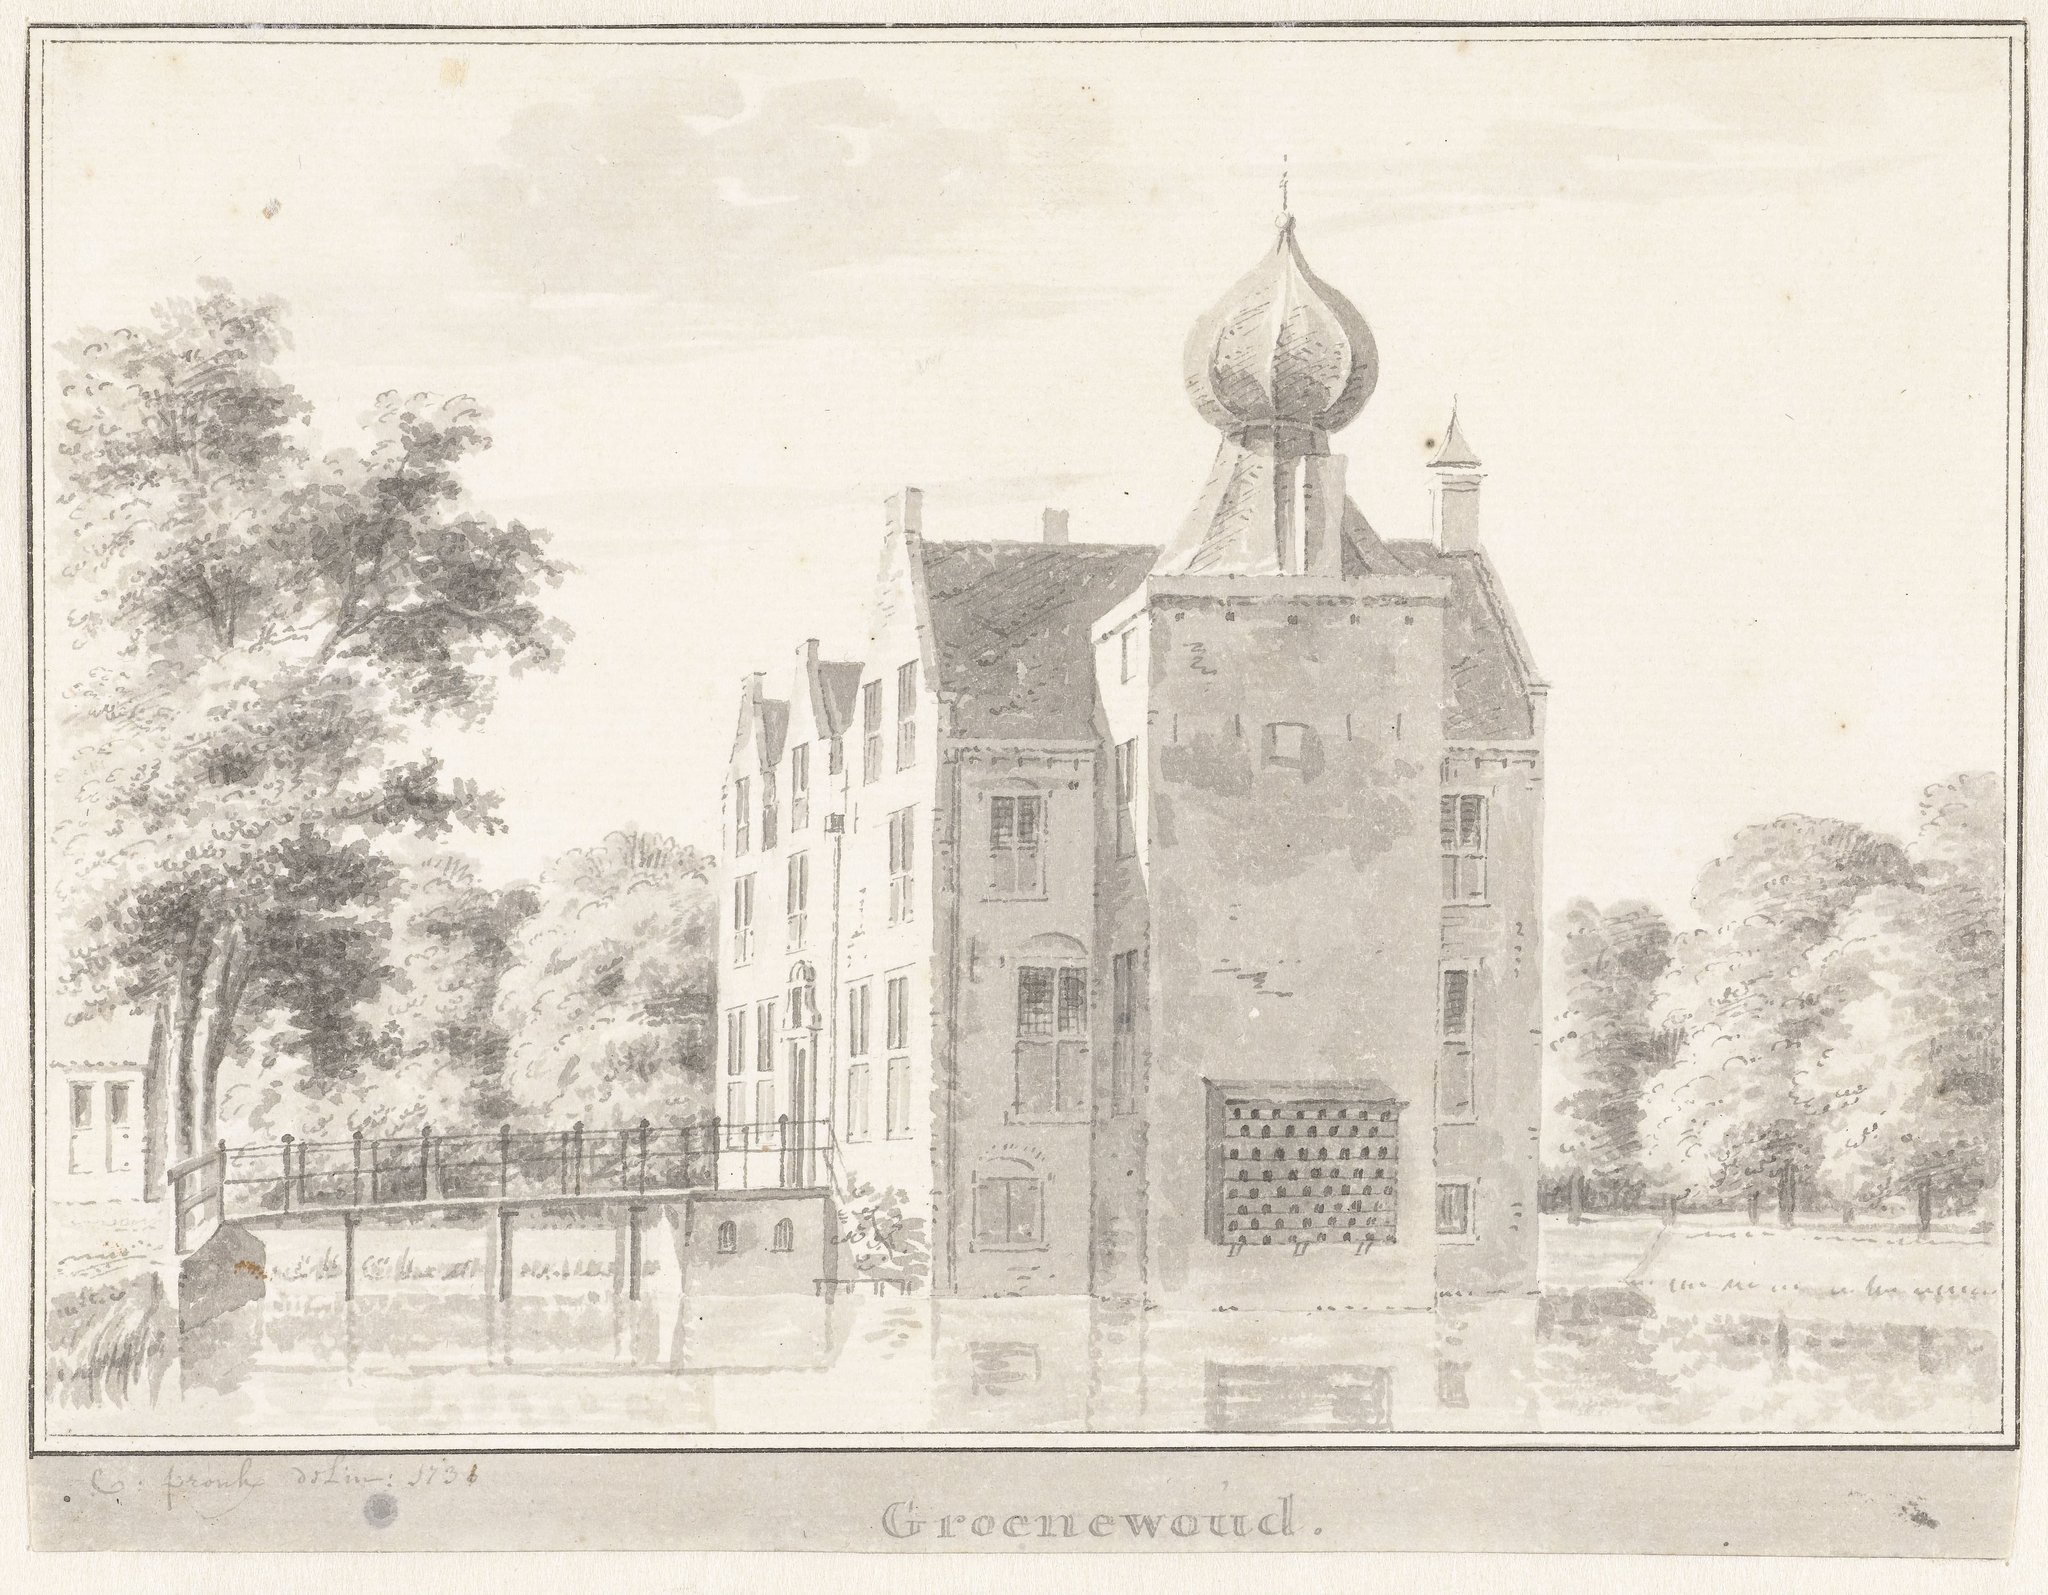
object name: drawing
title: Kasteel Groenewoude onder Amersfoort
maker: cornelis pronk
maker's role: draughtsman, painter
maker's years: 1691-1759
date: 1731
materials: ink, paper, pencil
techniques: brush, pen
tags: castle